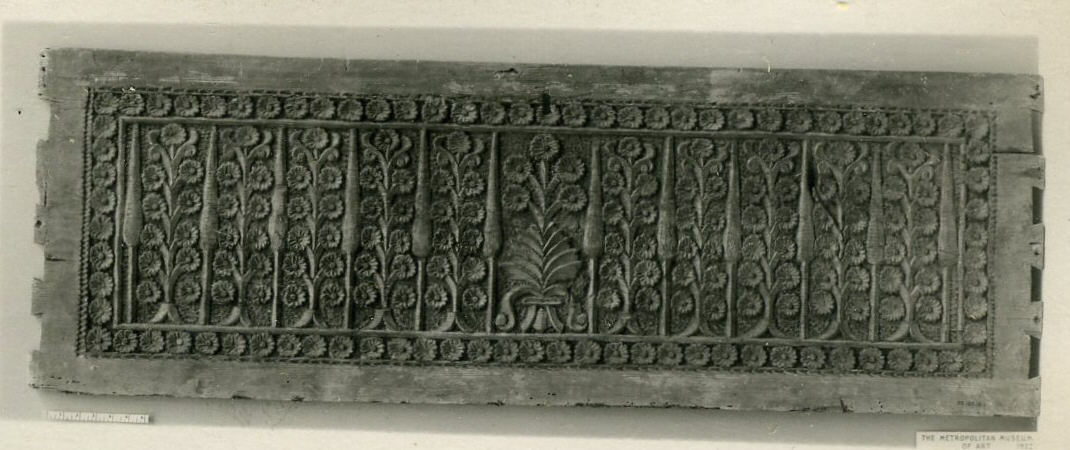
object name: chest front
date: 1701-1800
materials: wood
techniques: carving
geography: syria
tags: palmettes,furniture